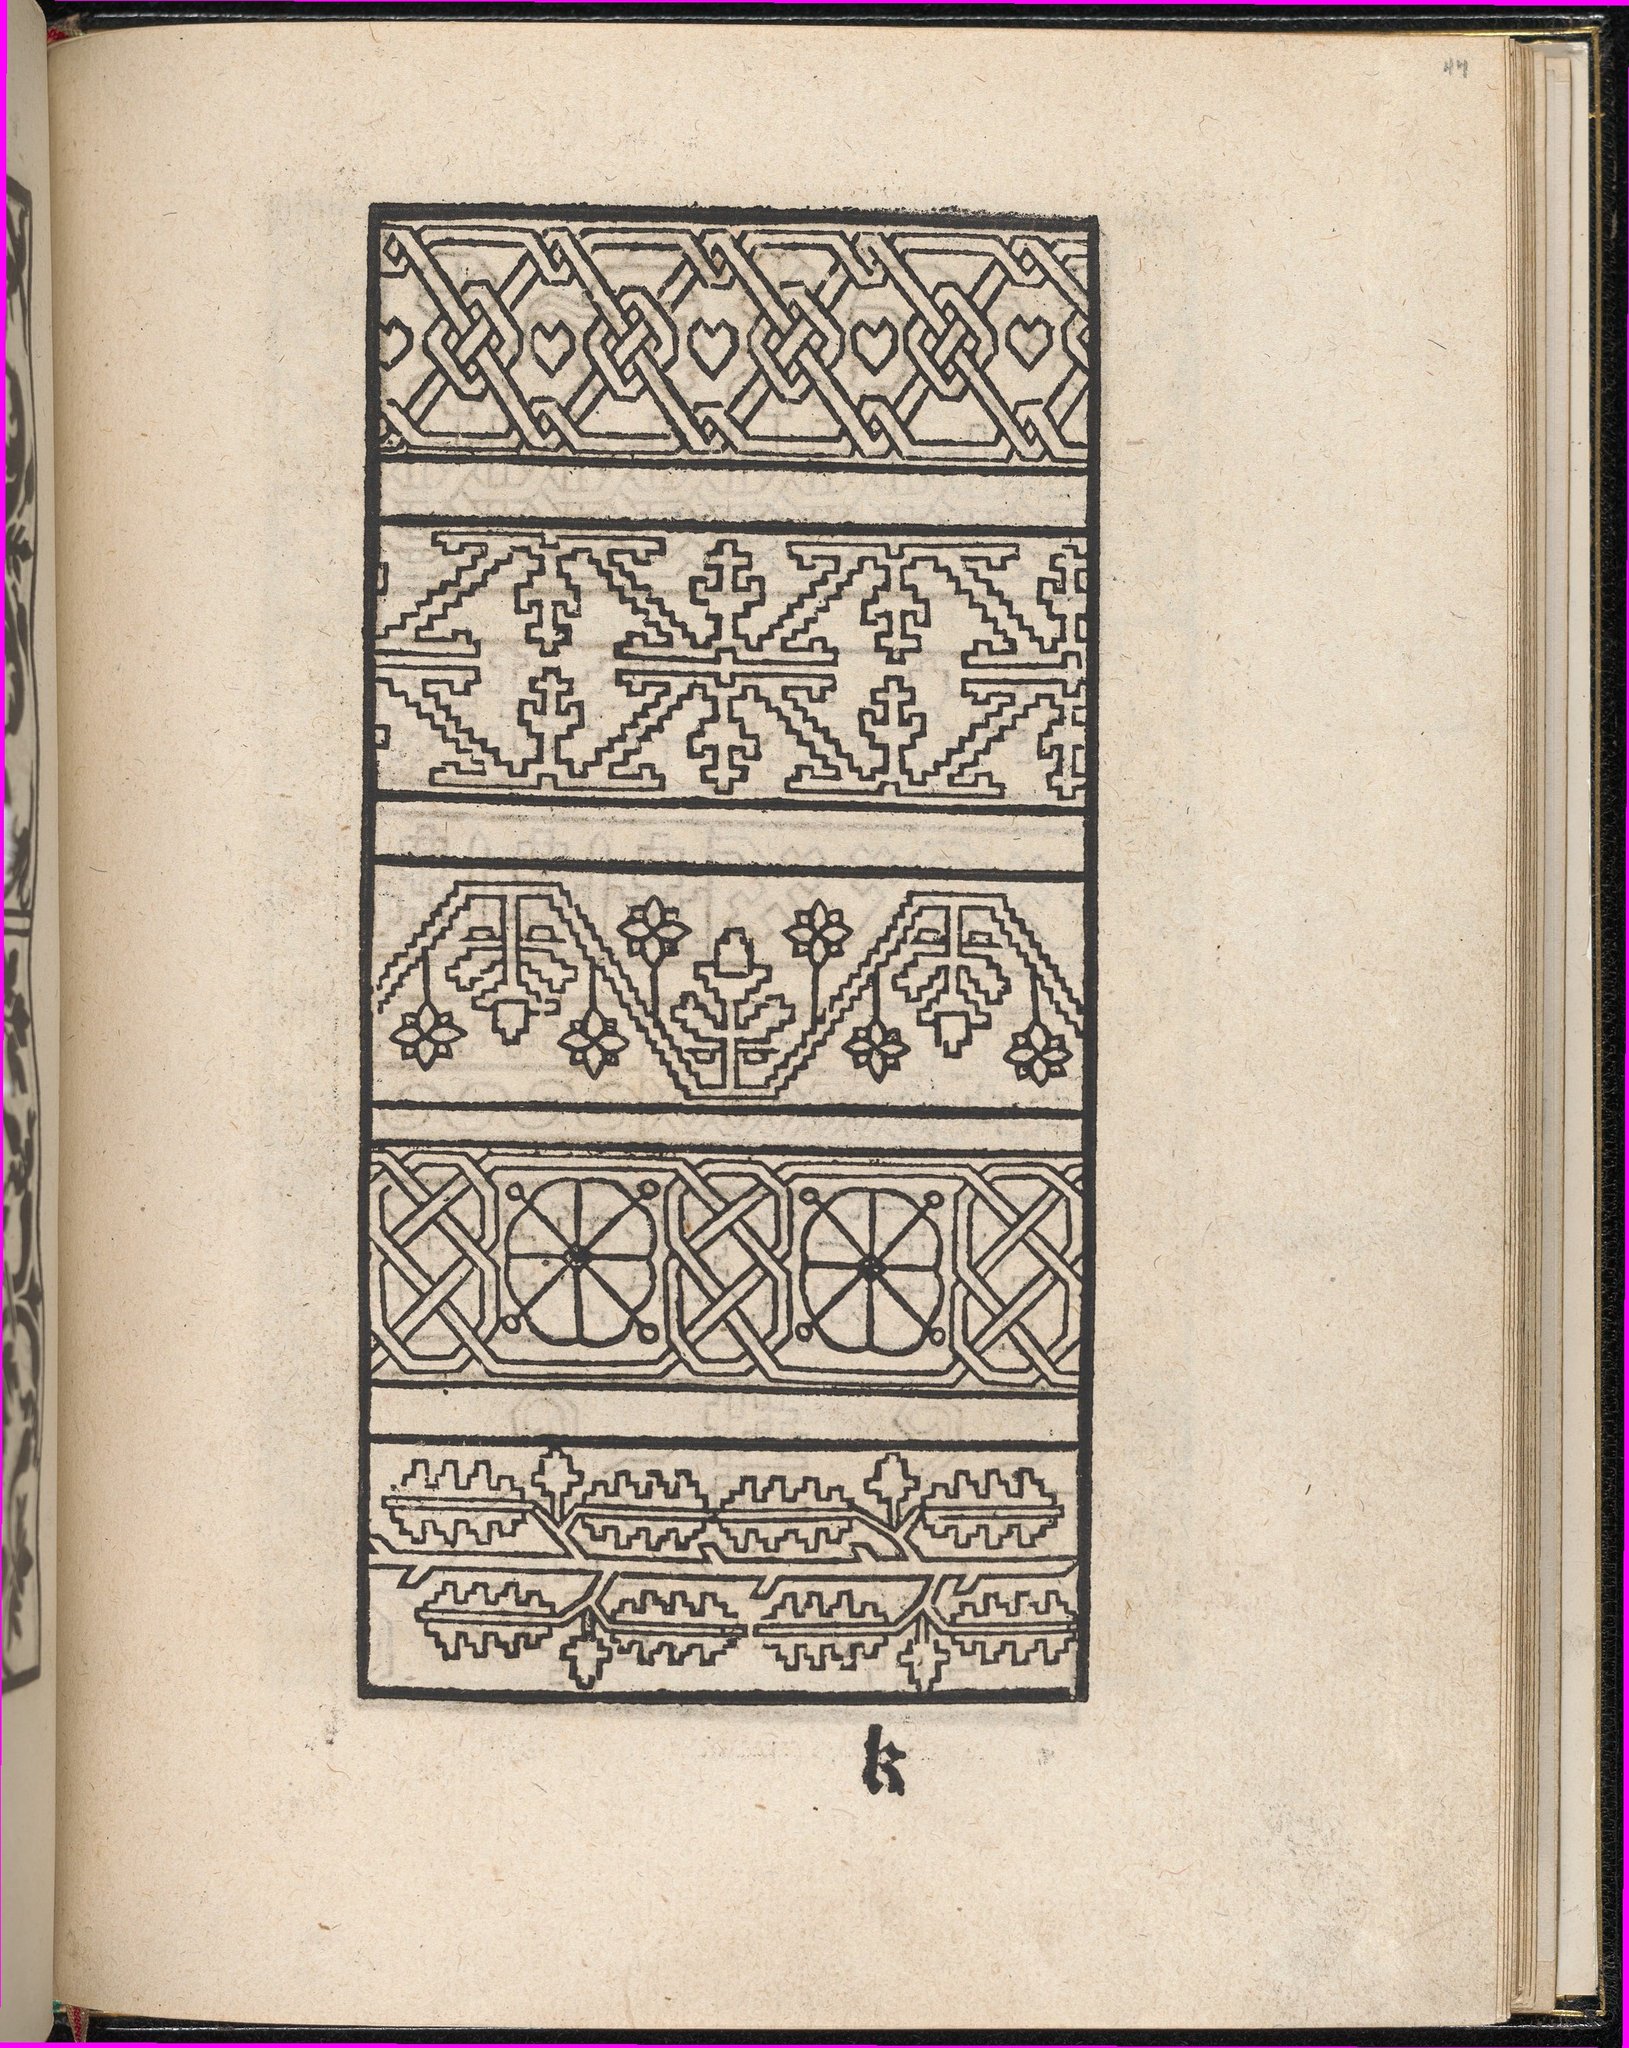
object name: book print ornament architecture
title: Page from Ein new kunstlich Modelbuch...(Page 44r)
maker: peter quentel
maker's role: publisher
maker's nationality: german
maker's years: 1500-1550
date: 1544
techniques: woodcut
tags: ornament